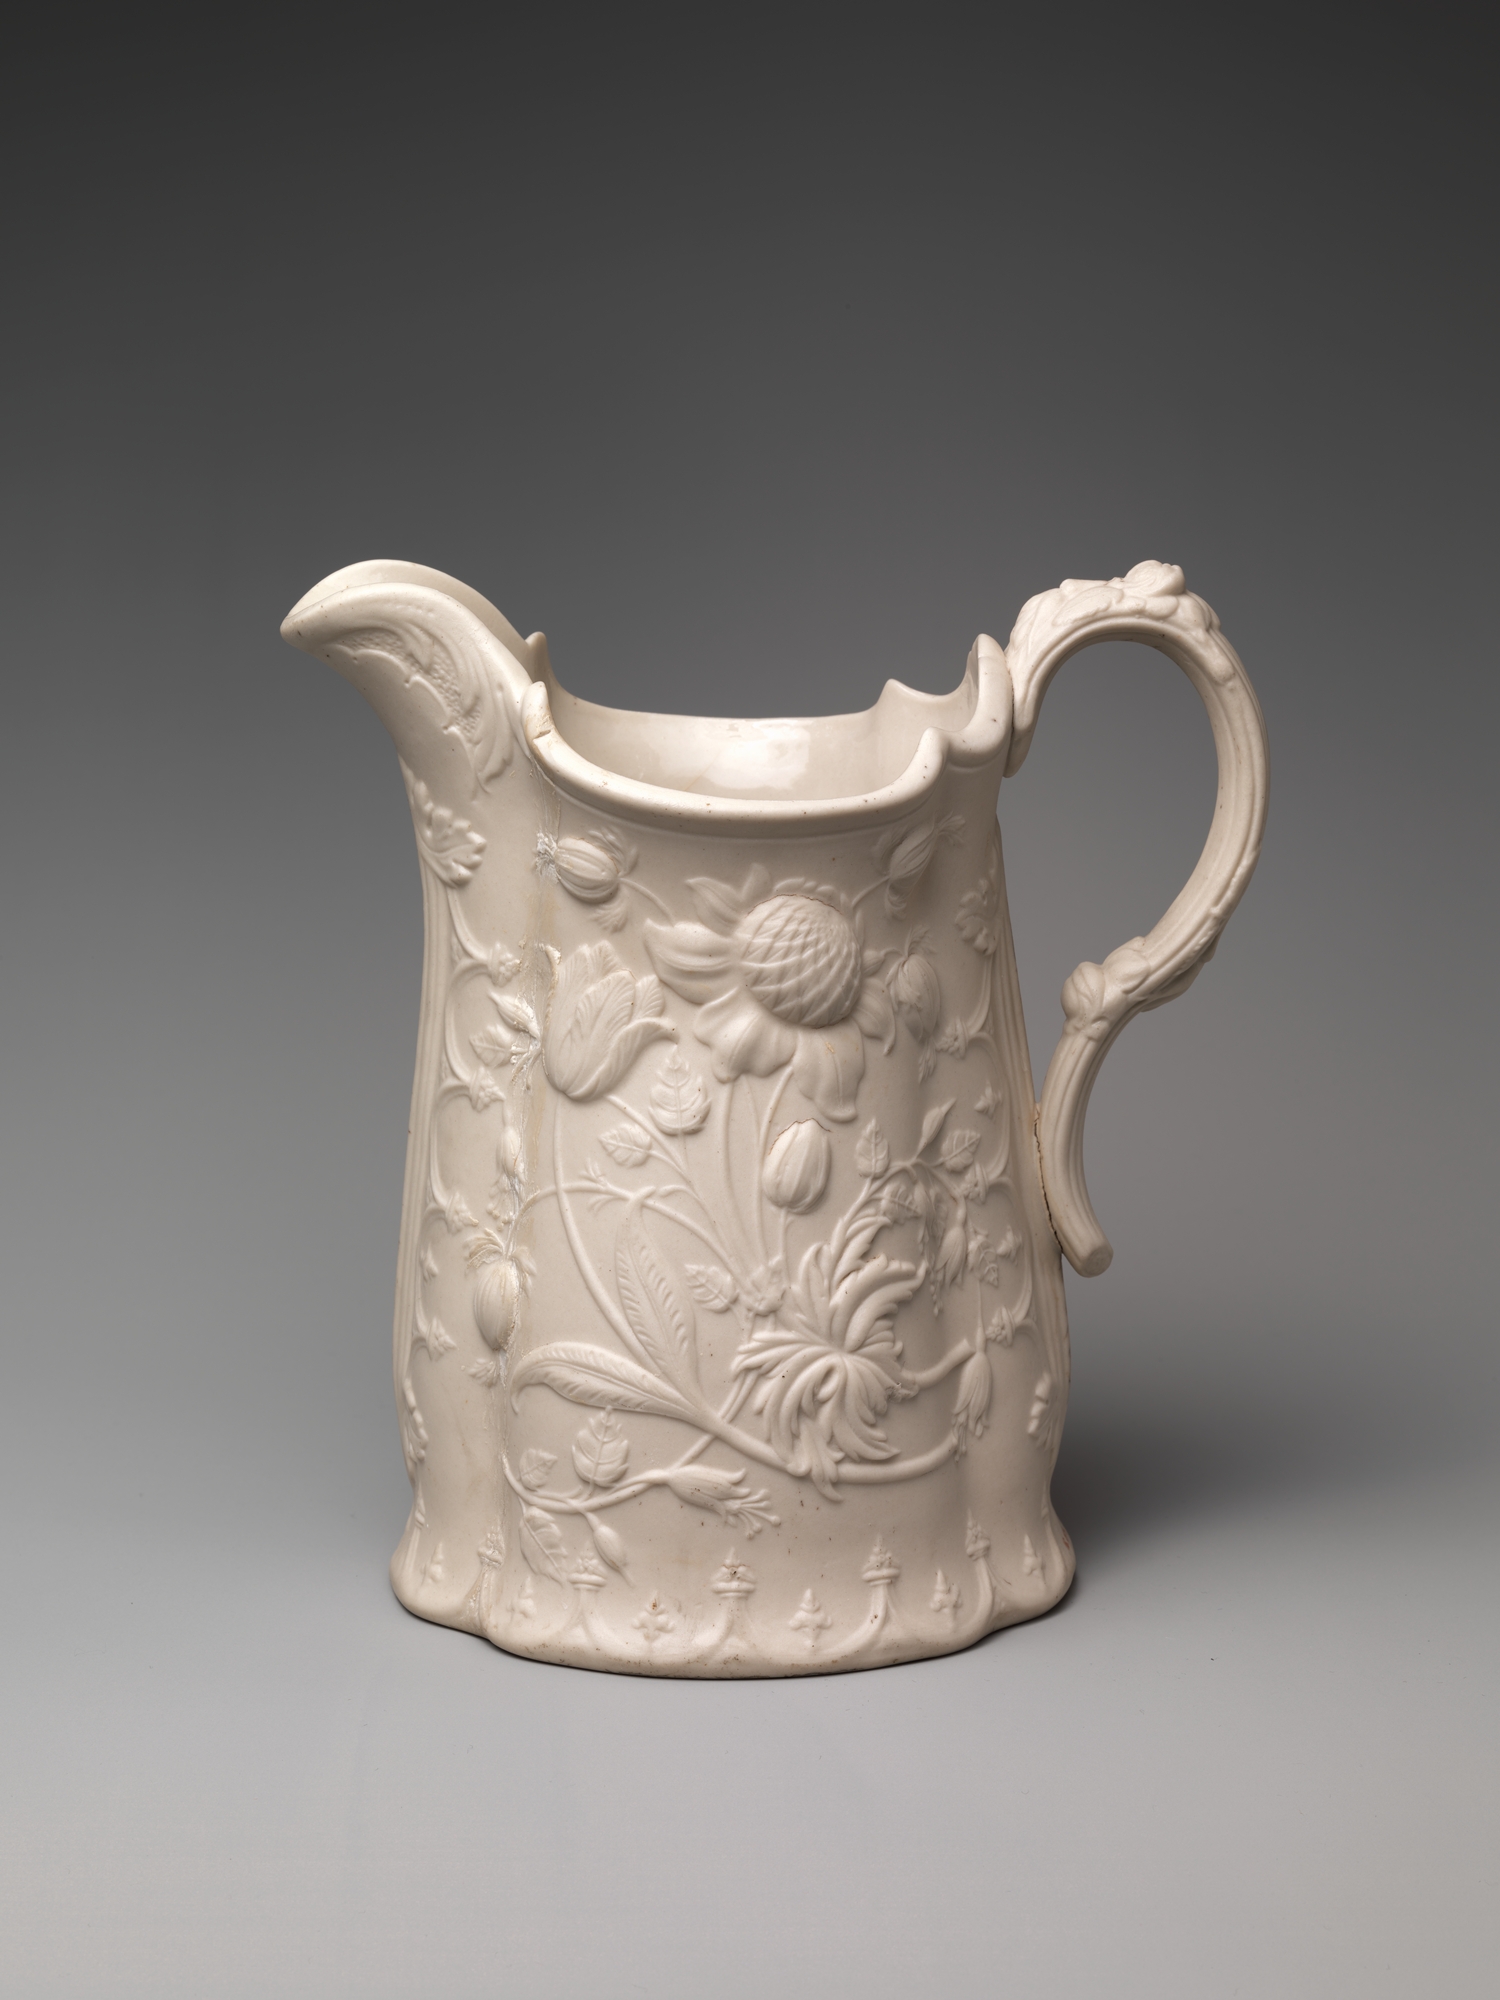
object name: jug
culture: american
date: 1800-1900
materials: porcelain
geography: united states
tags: flowers